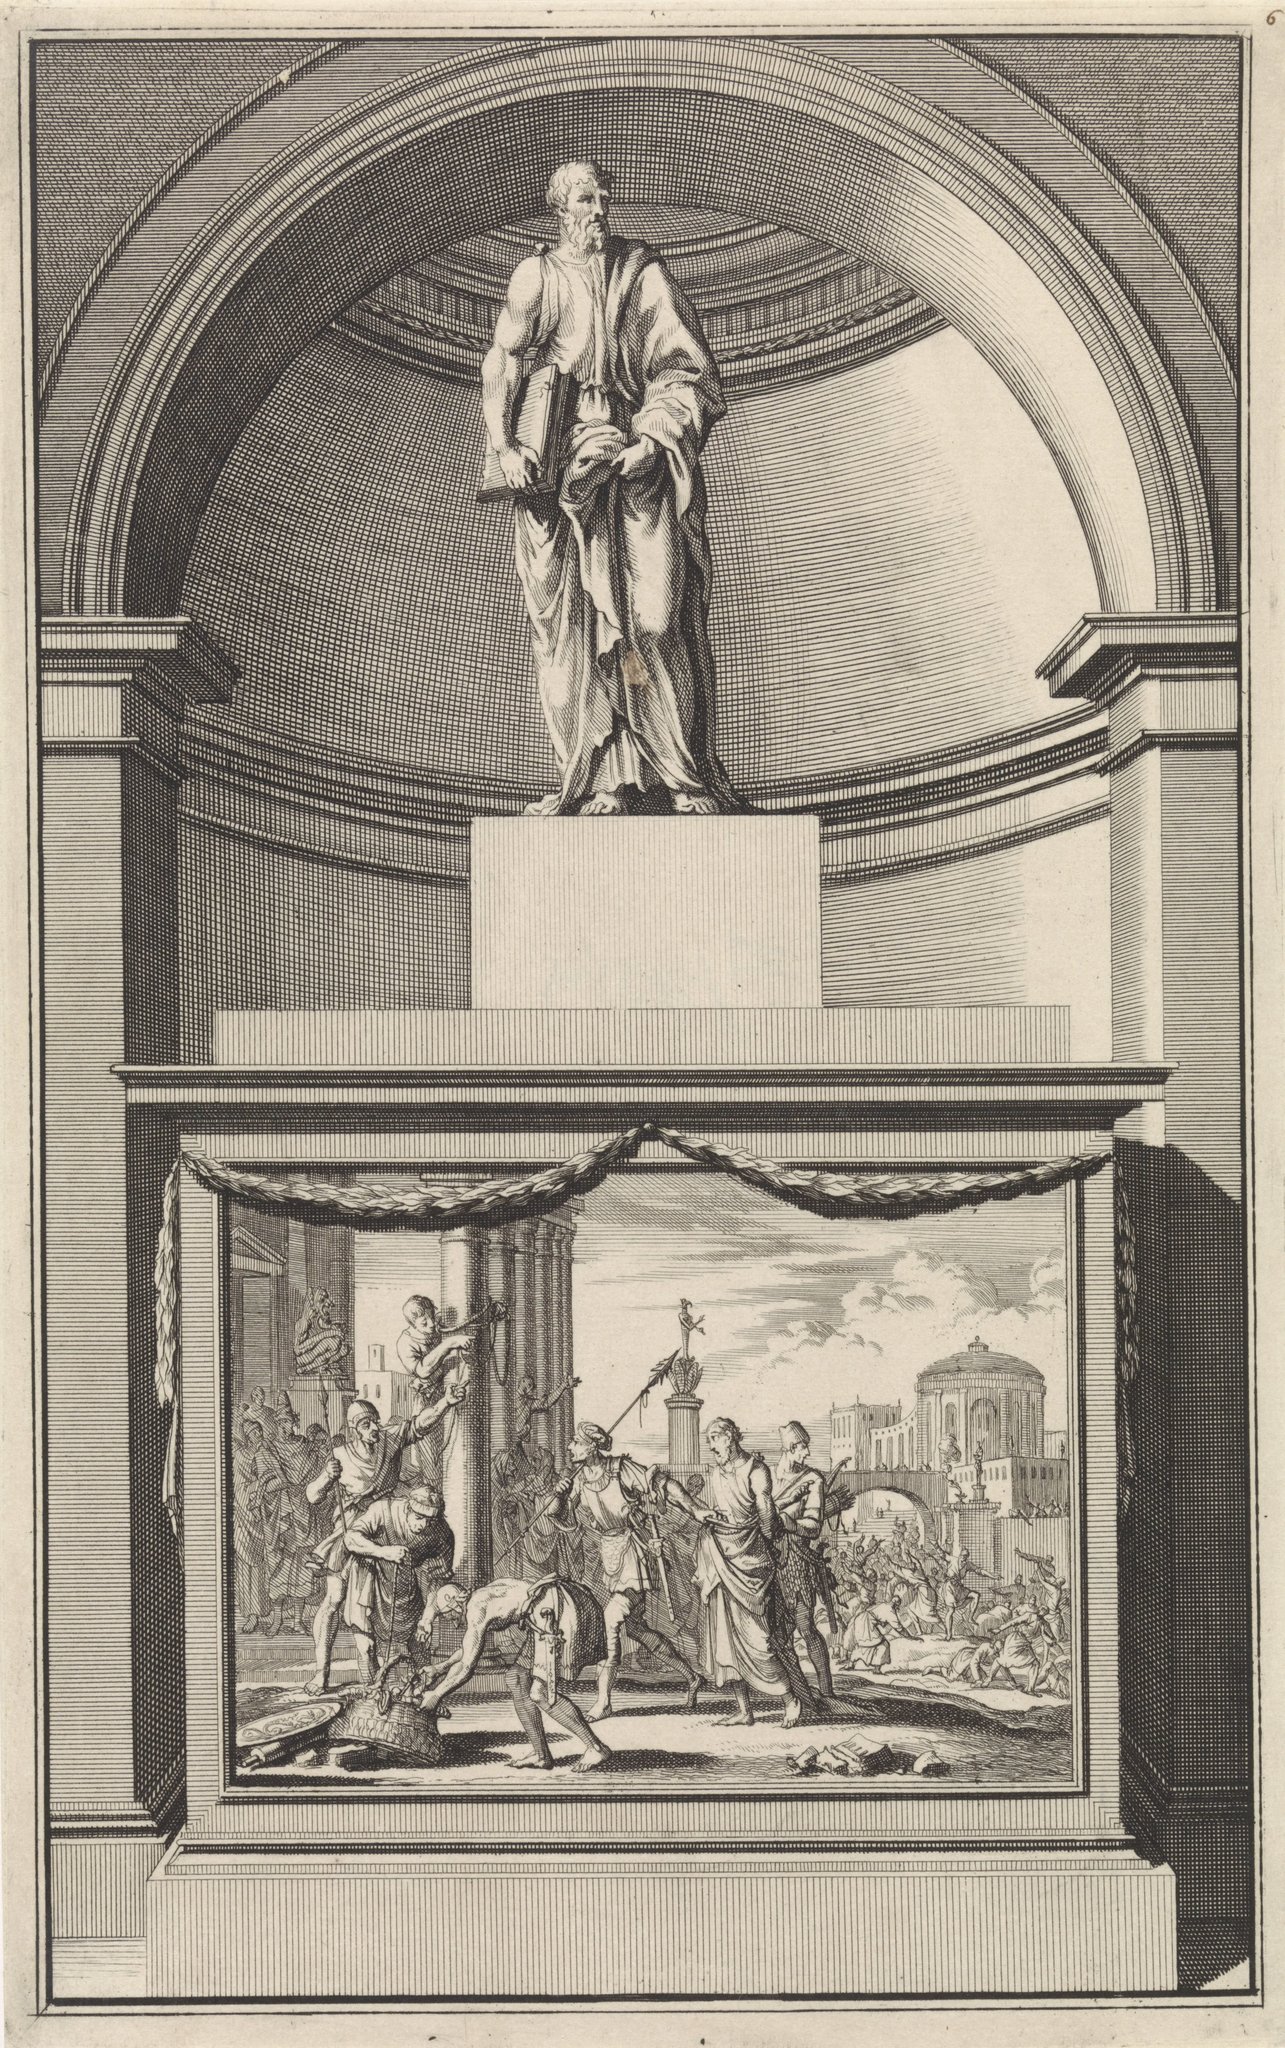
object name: print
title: Apostel Filippus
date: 1698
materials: paper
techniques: engraving, etching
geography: amsterdam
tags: the apostle philip; possible attributes: book, cross, dish with snake, lance, scroll, stone, sword, martyrdom and death of philip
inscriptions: collector's mark: Lugt 2228, number: ‘6’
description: Proefdruk van illustratie uit: Cave, William. Apostolische oudheden, of Het leven (...) der heylige apostelen, 3 delen. Utrecht: François Halma en Willem van de Water (I), 1698, p. 305.